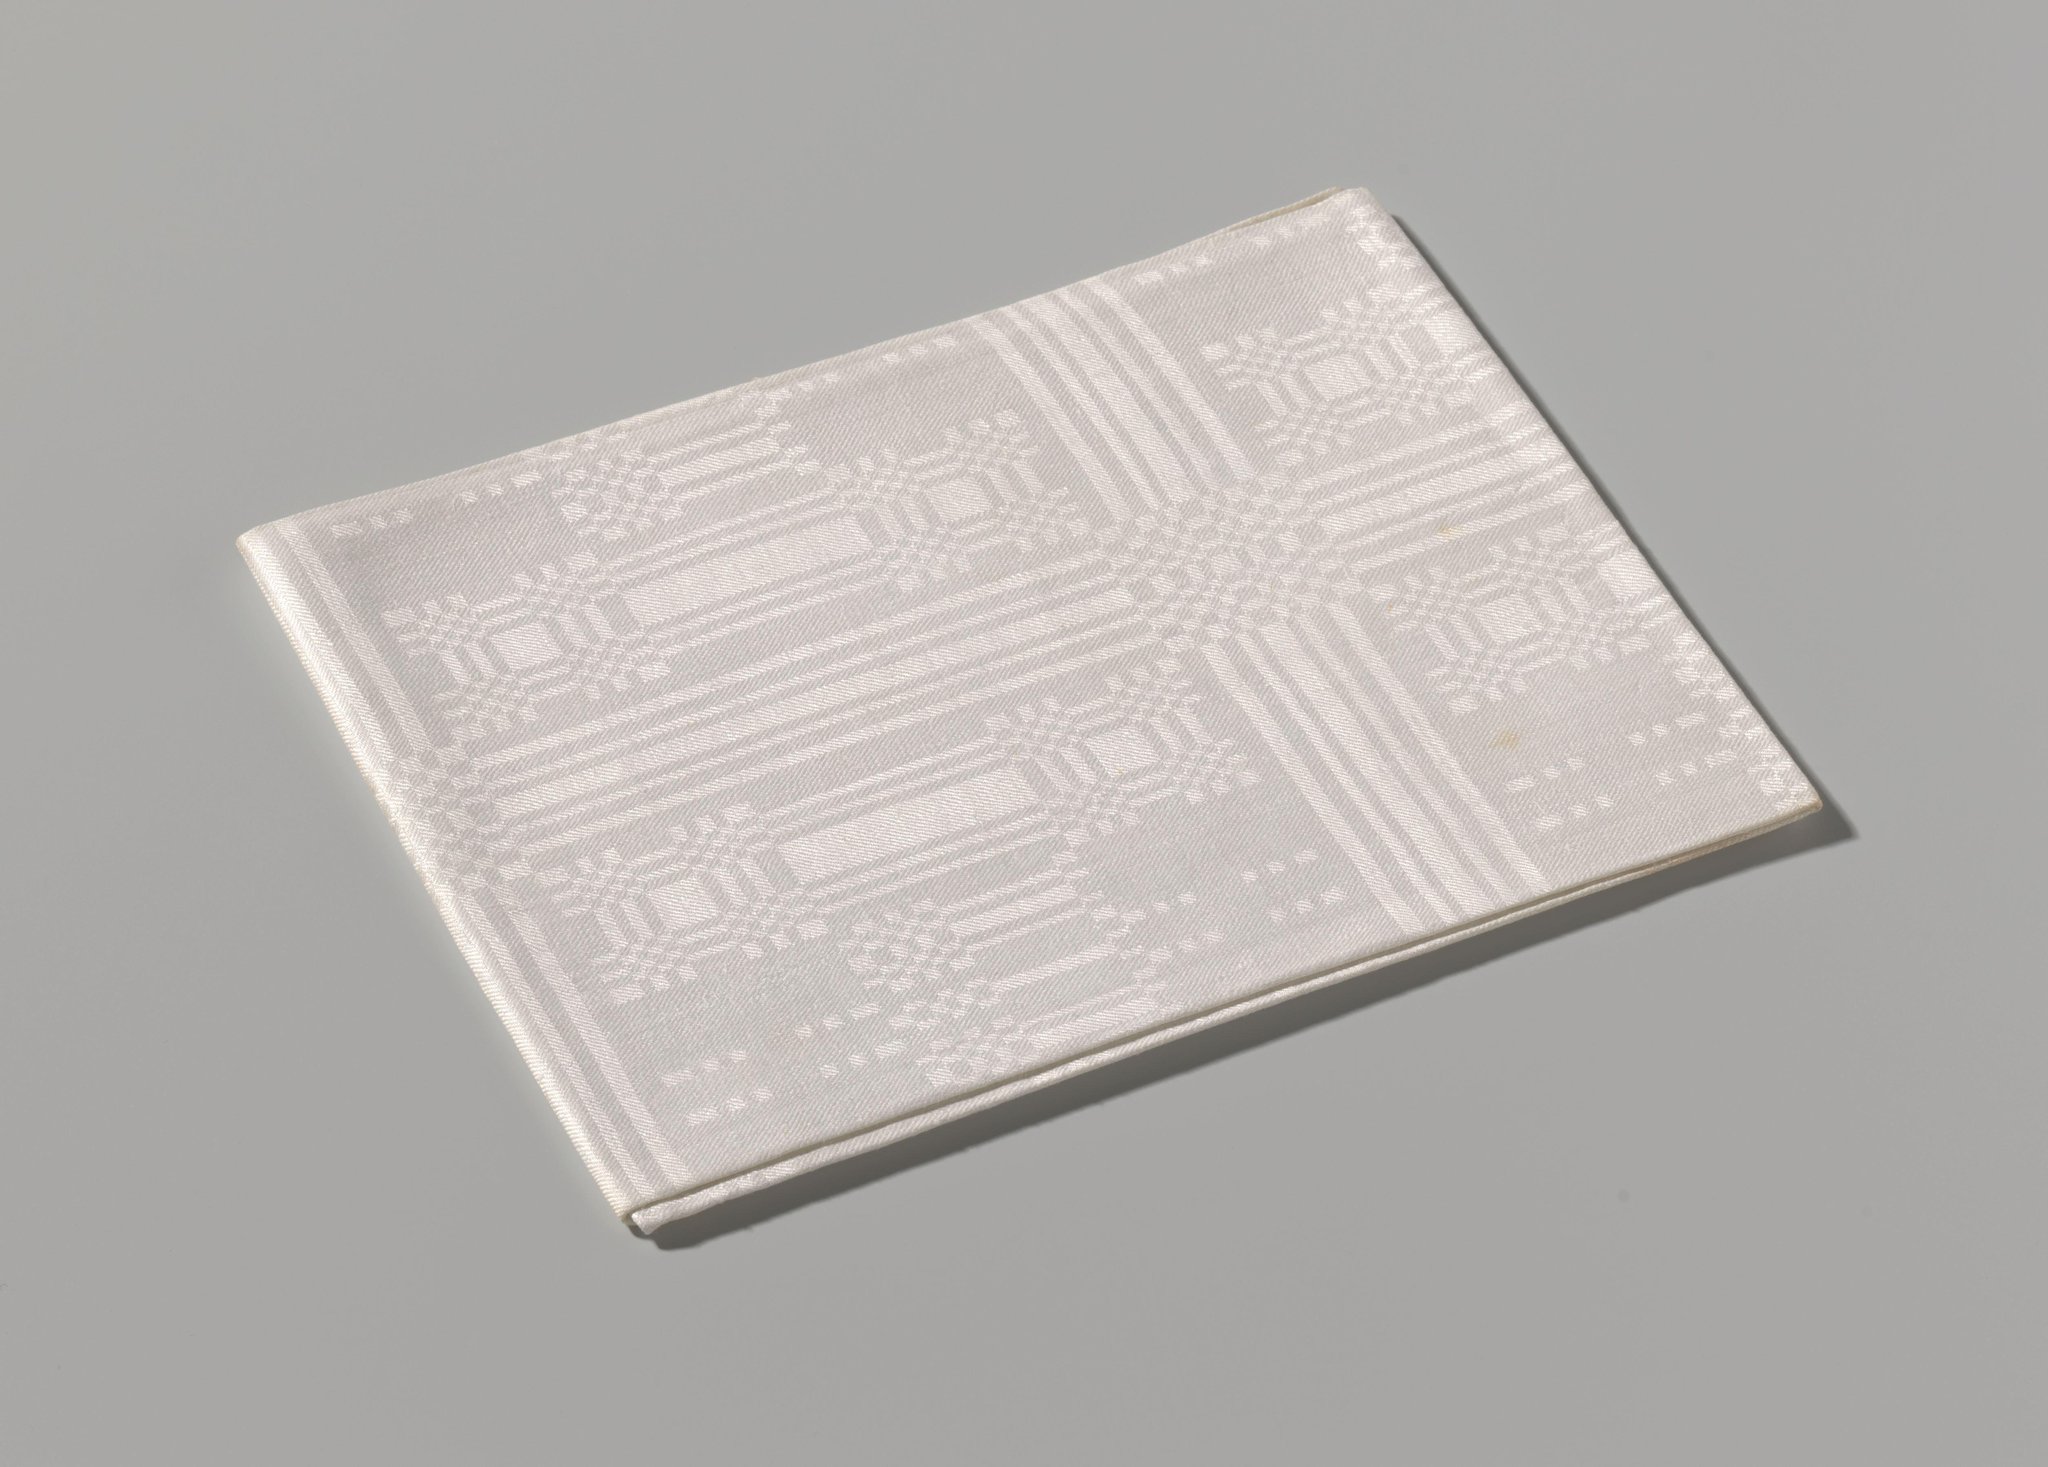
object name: napkin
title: Servet van linnen met pellenpatroon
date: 1740-1786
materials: linen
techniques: twill, peeled fabric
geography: northern netherlands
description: wit linnen servet met pellen patroon, merk kroon IAVG 36